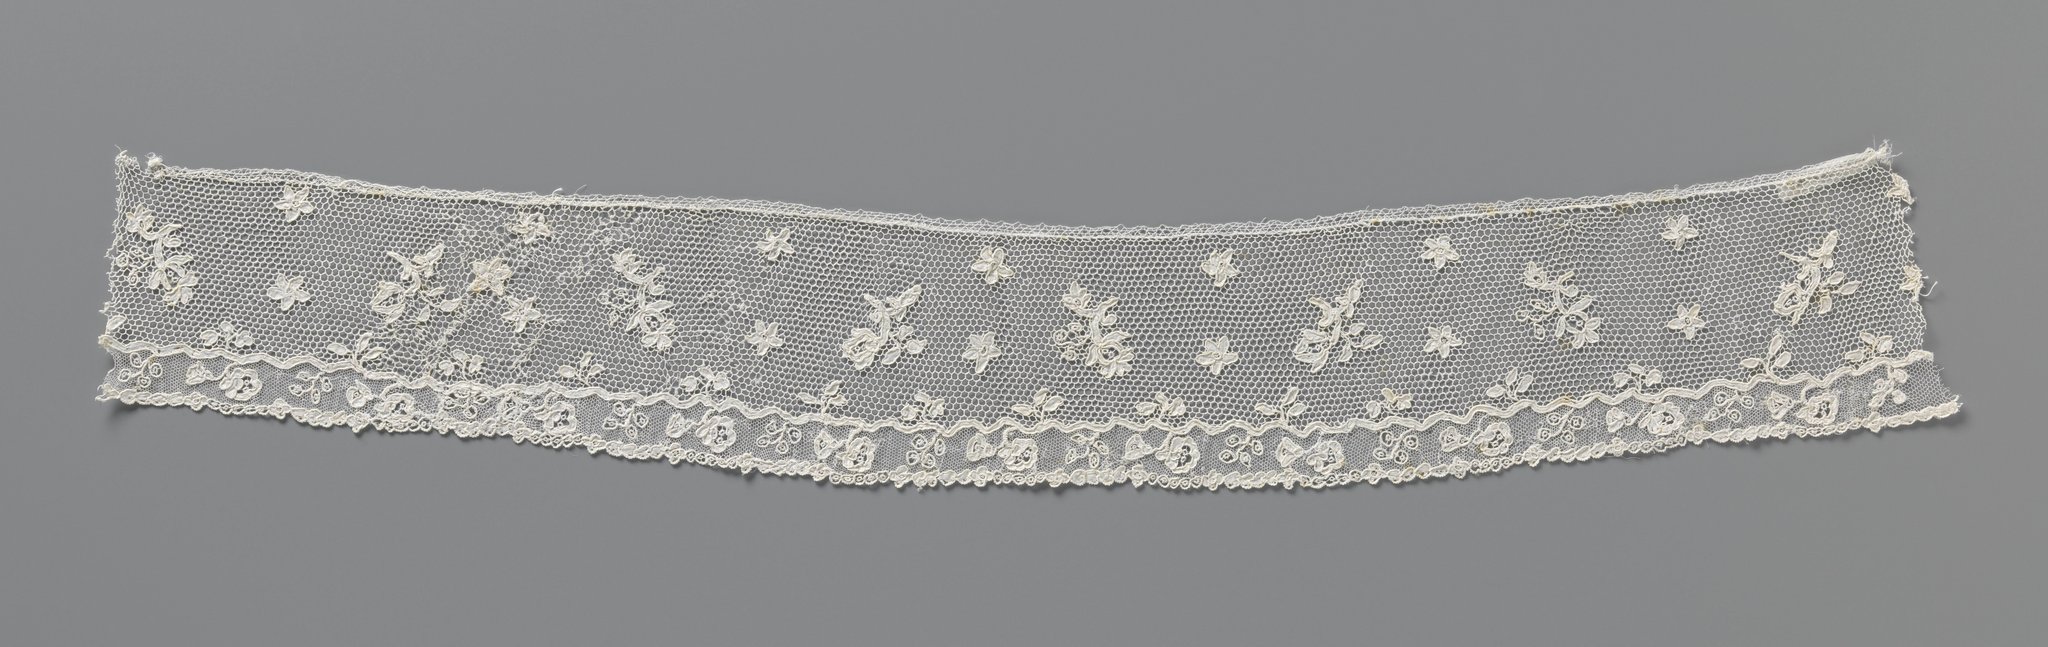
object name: strip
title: Strook naaldkant met bloemtakken en stervormige bloemen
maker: Anonymous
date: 1795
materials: linen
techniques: lace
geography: argentan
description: Strook naturelkleurig naaldkant, Argentankant en Alençonkant. Repetitief motief met twee verschillende bloemtakken, elk geflankeerd door twee boven elkaar geplaatste stervormige bloemen, op een grond met mazen die dicht omnaaid zijn met knoopsgatensteken (Argentankant). De bloemtakken buigen om en om naar elkaar toe. Langs de onderzijde onder een golvende lijn waaronder een patroon van bloemen en bessen op een fijne zeshoekige maasgrond (Alençonkant). Siergrond met raderpicots in de grotere bloemen en de cirkeltjes langs de onderrand. Volwerk met minimale uitsparingen binnen de contouren van de overige motieven. Schulpenrand aan de onderzijde door een aaneenschakeling van cirkeltjes, op regelmatige afstand onderbroken door een rozetbloempje. De bovenzijde is afgezet met een rand kloskant.